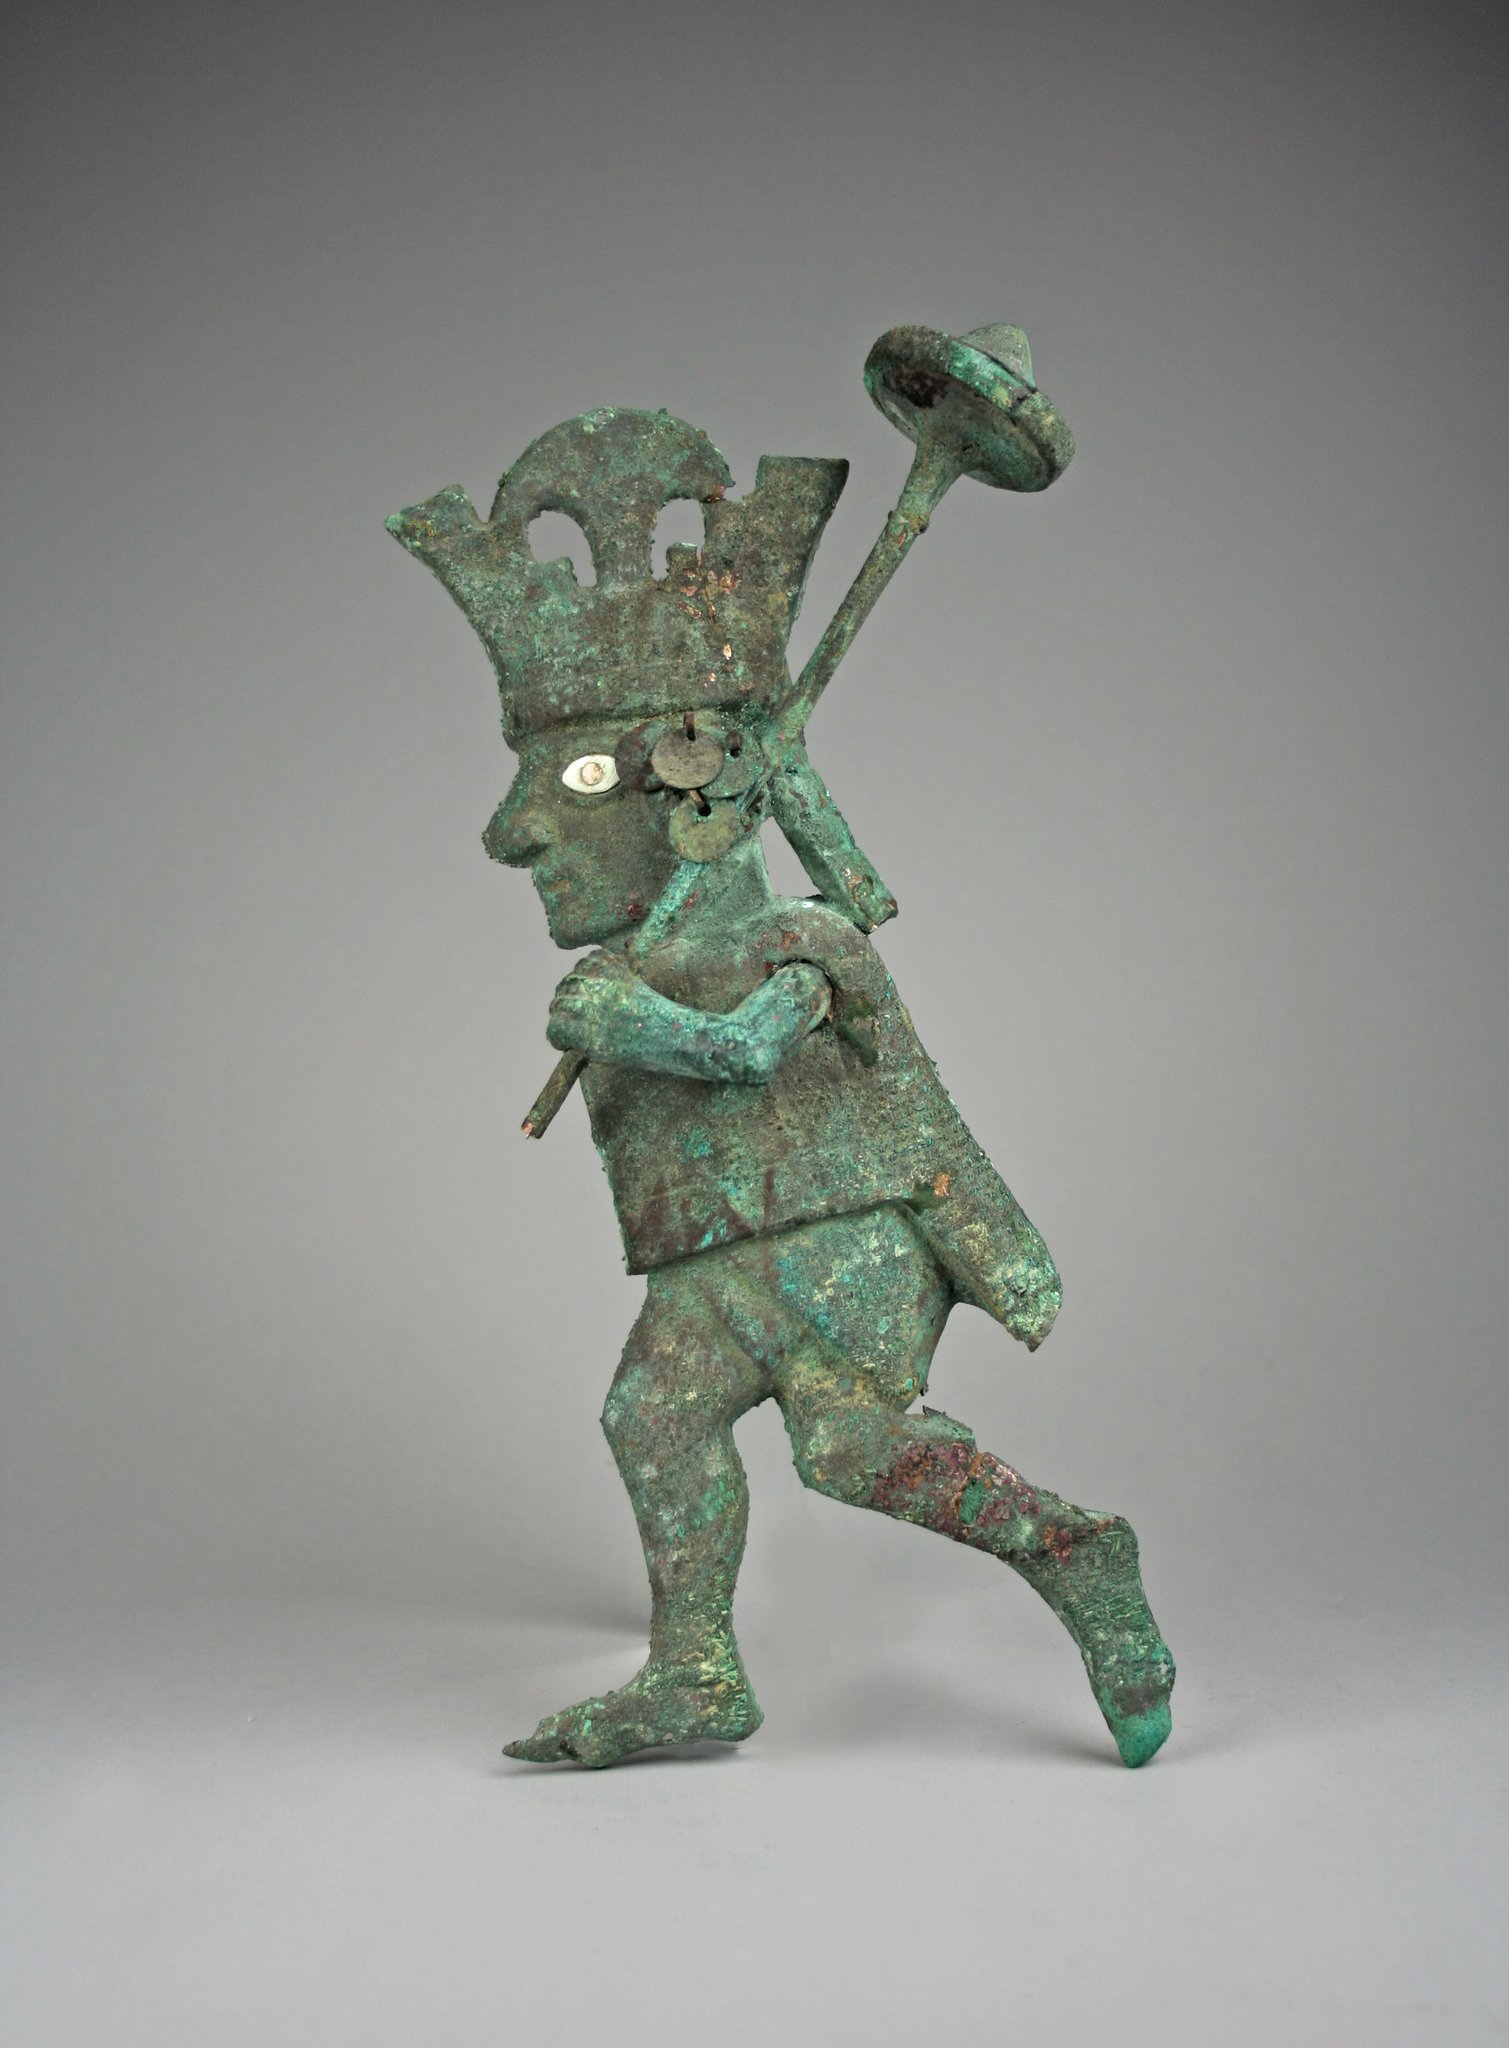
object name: ornament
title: Profile Warrior Ornament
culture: moche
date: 501-700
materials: copper, shell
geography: peru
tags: weapons,men,profiles